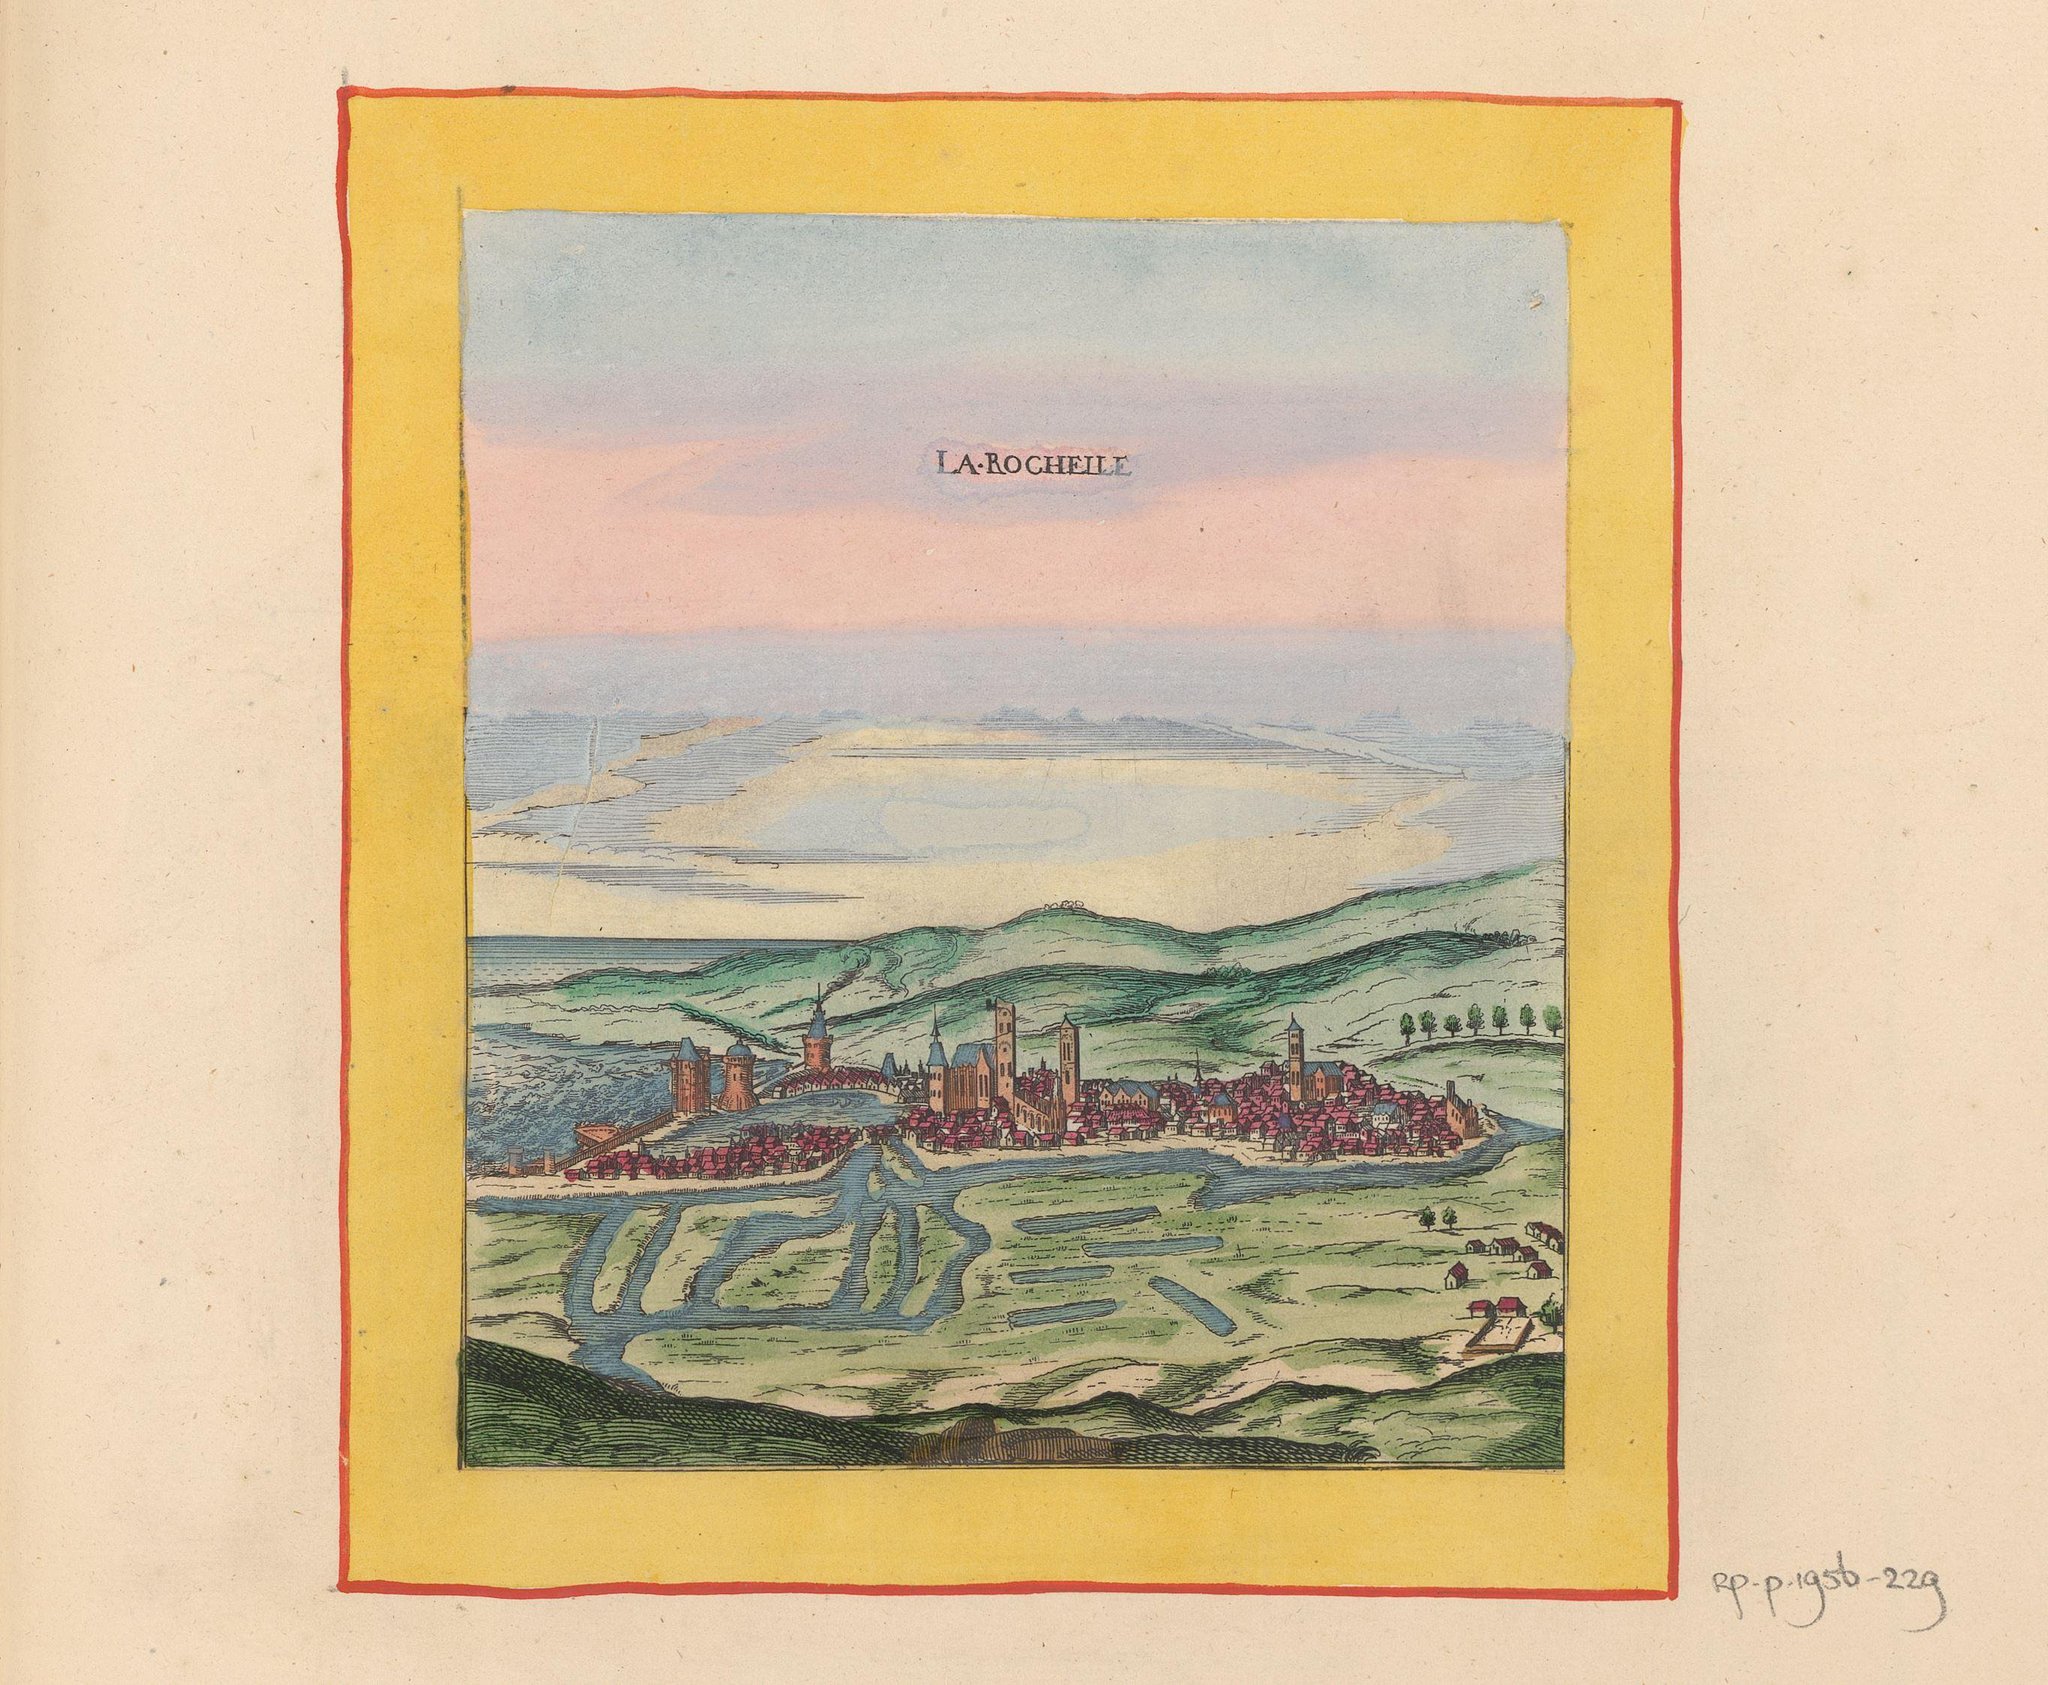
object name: print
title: La Rochelle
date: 1638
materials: paper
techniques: engraving, etching, hand coloring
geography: the hague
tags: city-view in general; 'veduta'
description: Prent uit: Tassin, Christophe. Les plans et profils de toutes les principales villes et lieux considérables de France (...). Parijs: Michel van Lochom, 1638, prent nummer 4 in het deel 'Poictou'.